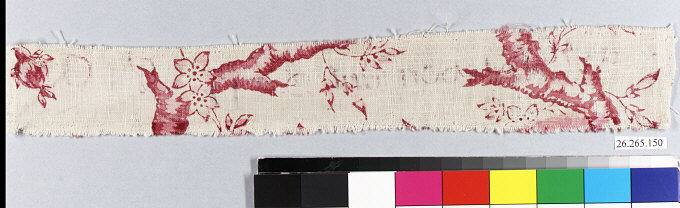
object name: piece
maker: gorgerat frères et cie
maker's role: manufactory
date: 1781-1815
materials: cotton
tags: flowers,leaves